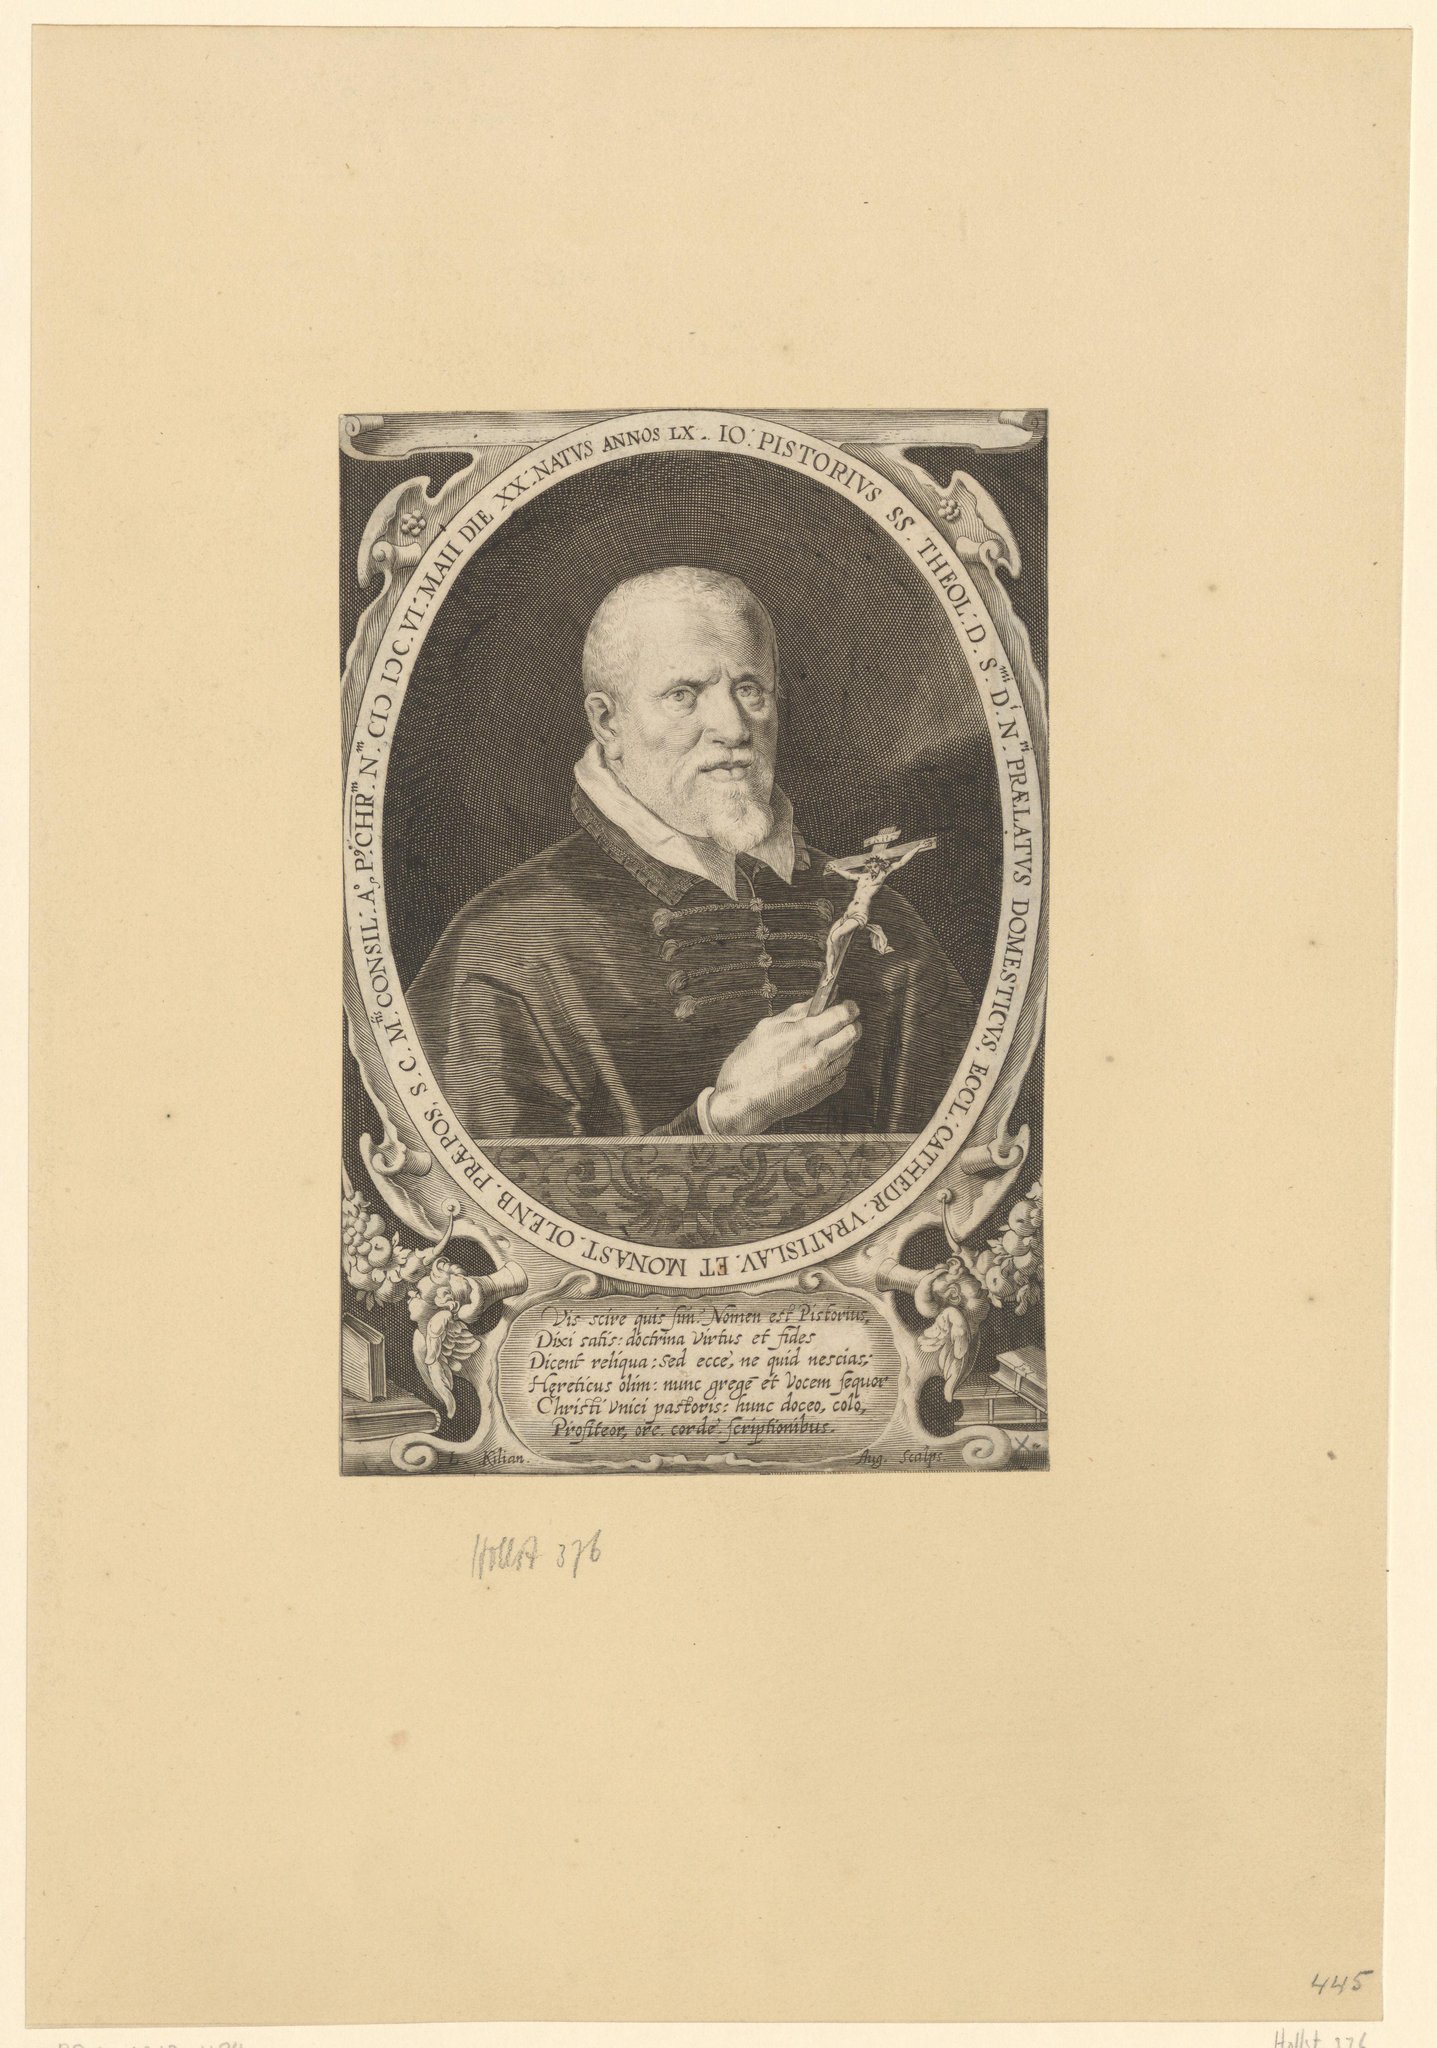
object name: print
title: Portret van Johann Pistorius op 60-jarige leeftijd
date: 1606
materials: paper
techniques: engraving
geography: augsburg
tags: history and archaeology (+ portrait of scholar, scientist), auricular ornament, lobe style ~ ornament, historical persons, crucifix ~ personal devotion, physician, doctor (+ portrait of scholar, scientist)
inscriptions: collector's mark: Lugt 2233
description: Tekst in het Latijn in de omlijsting en in de cartouche.